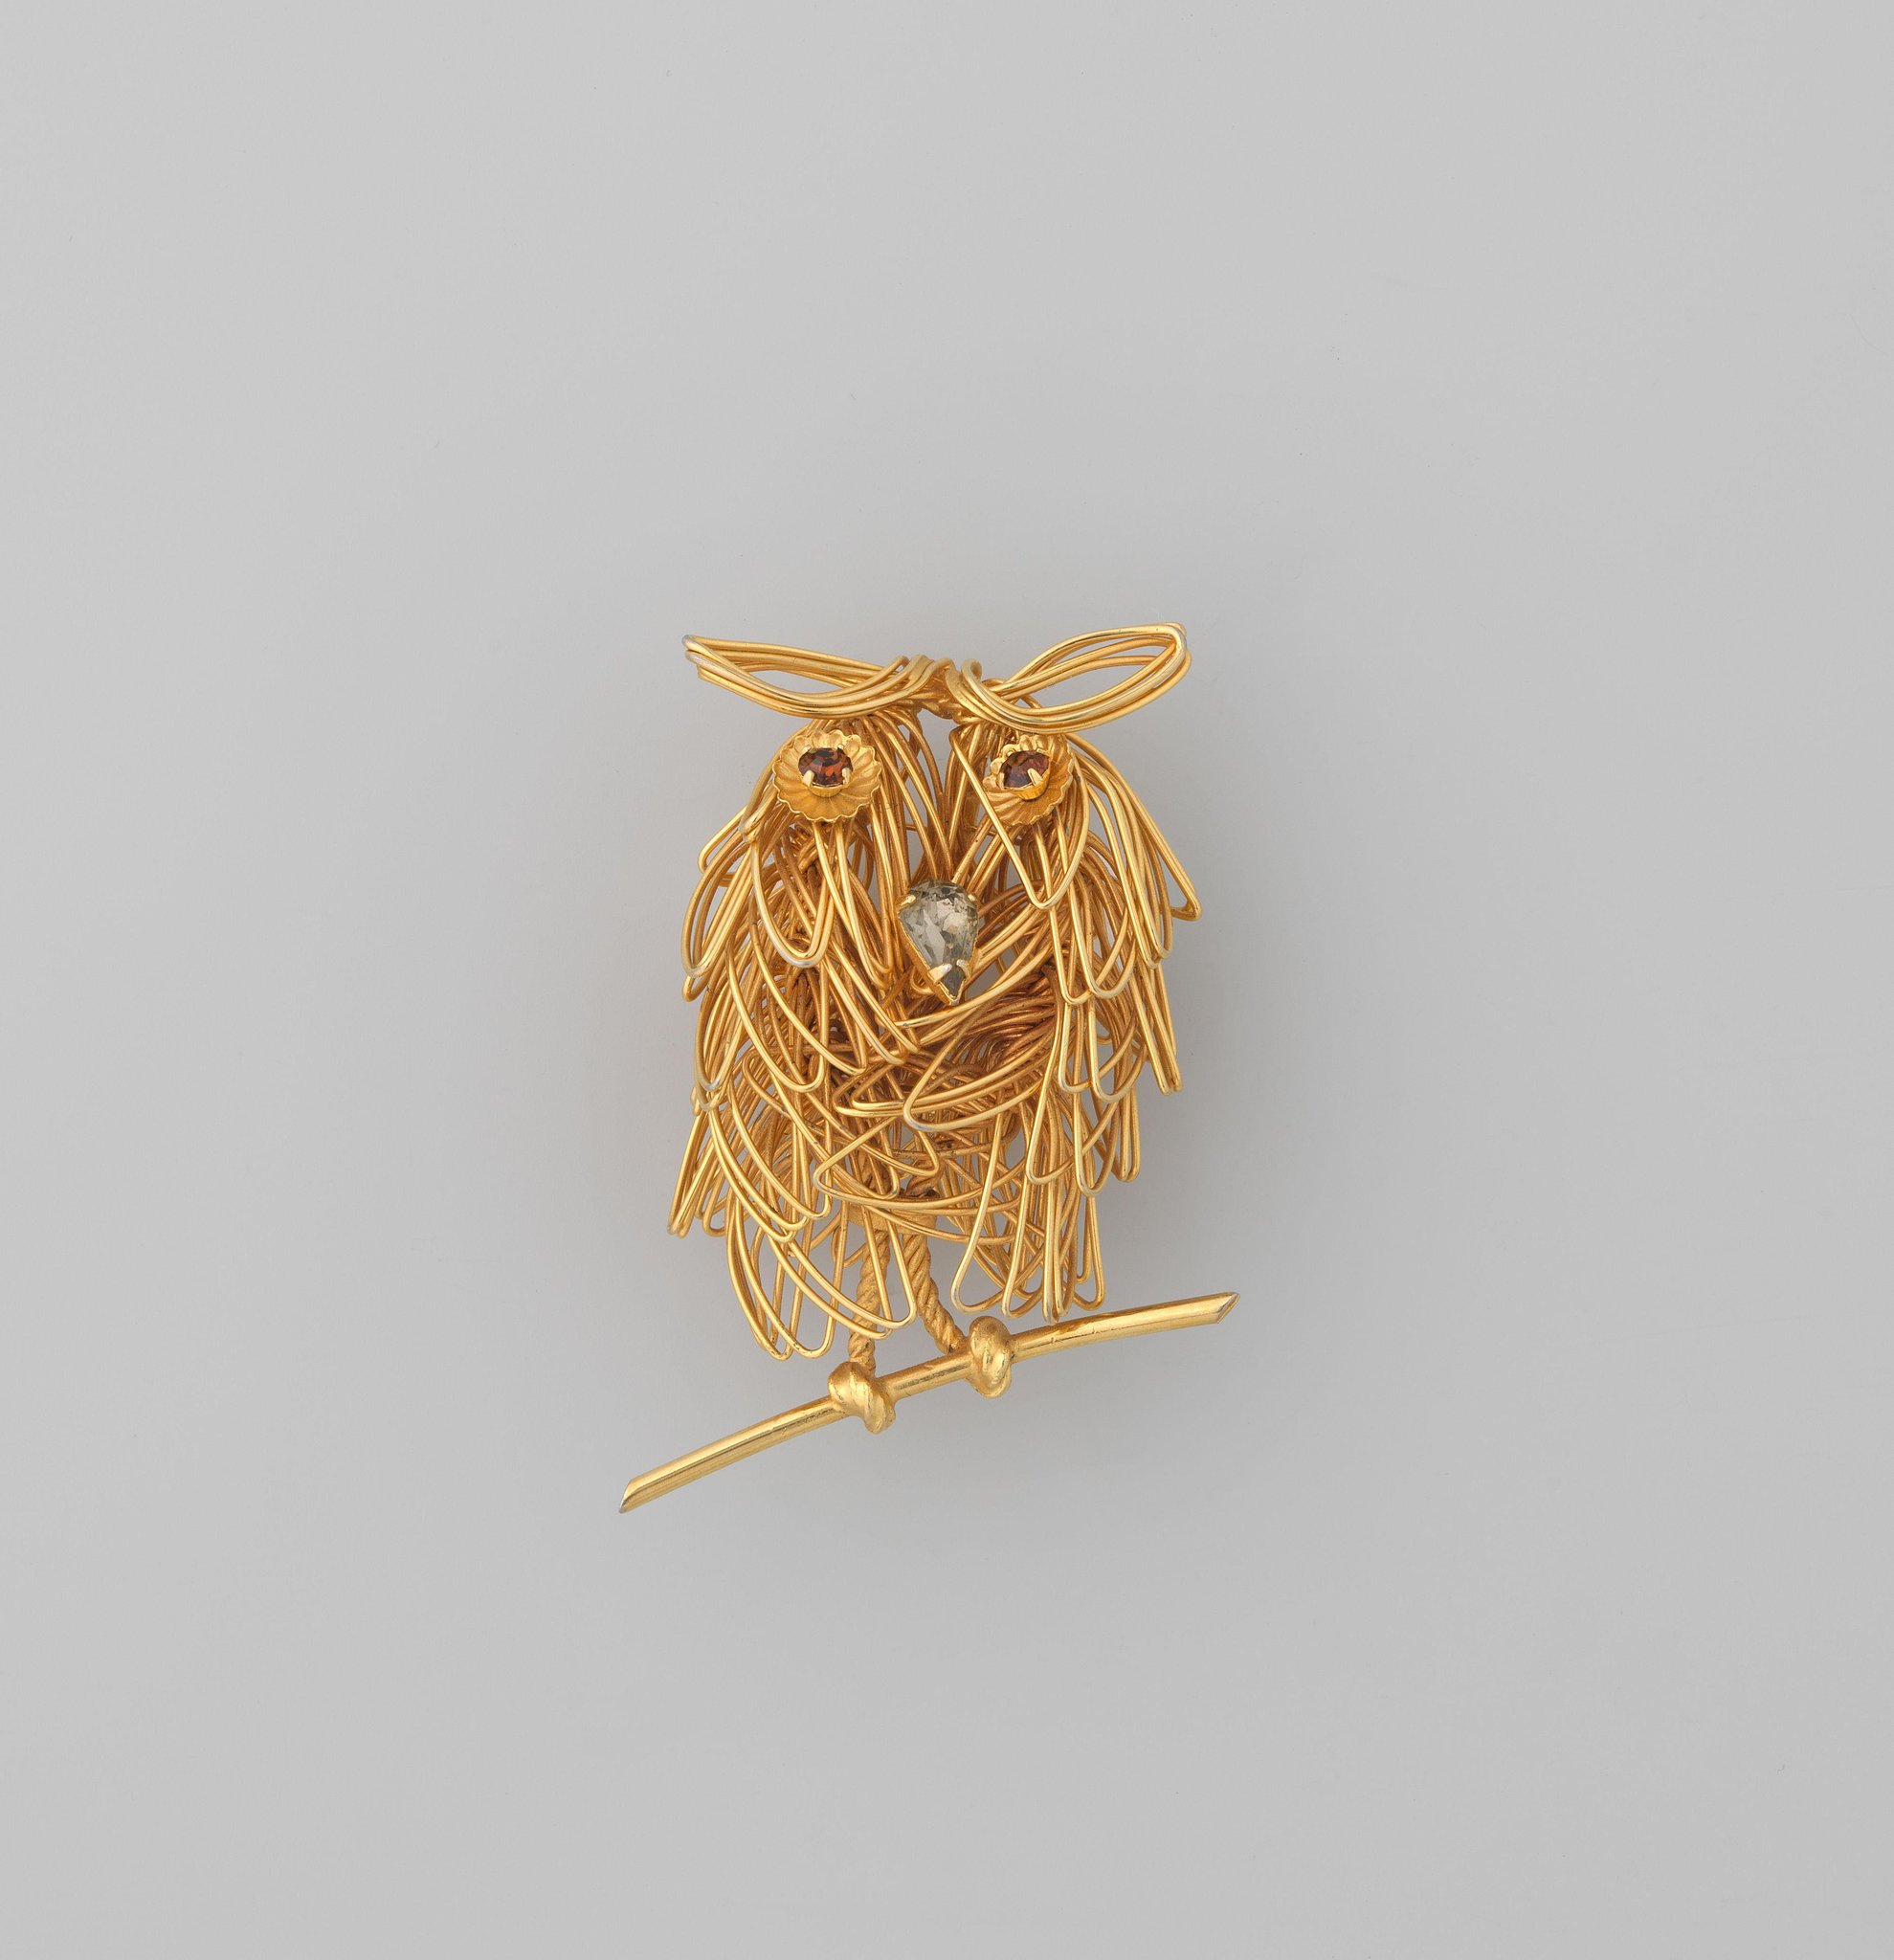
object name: brooch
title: Uil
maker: Anonymous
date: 1950-1960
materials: glass, metal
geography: germany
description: Broche van goudkleurig metaaldraad in de vorm van een uil voorzien van kanonsluiting.